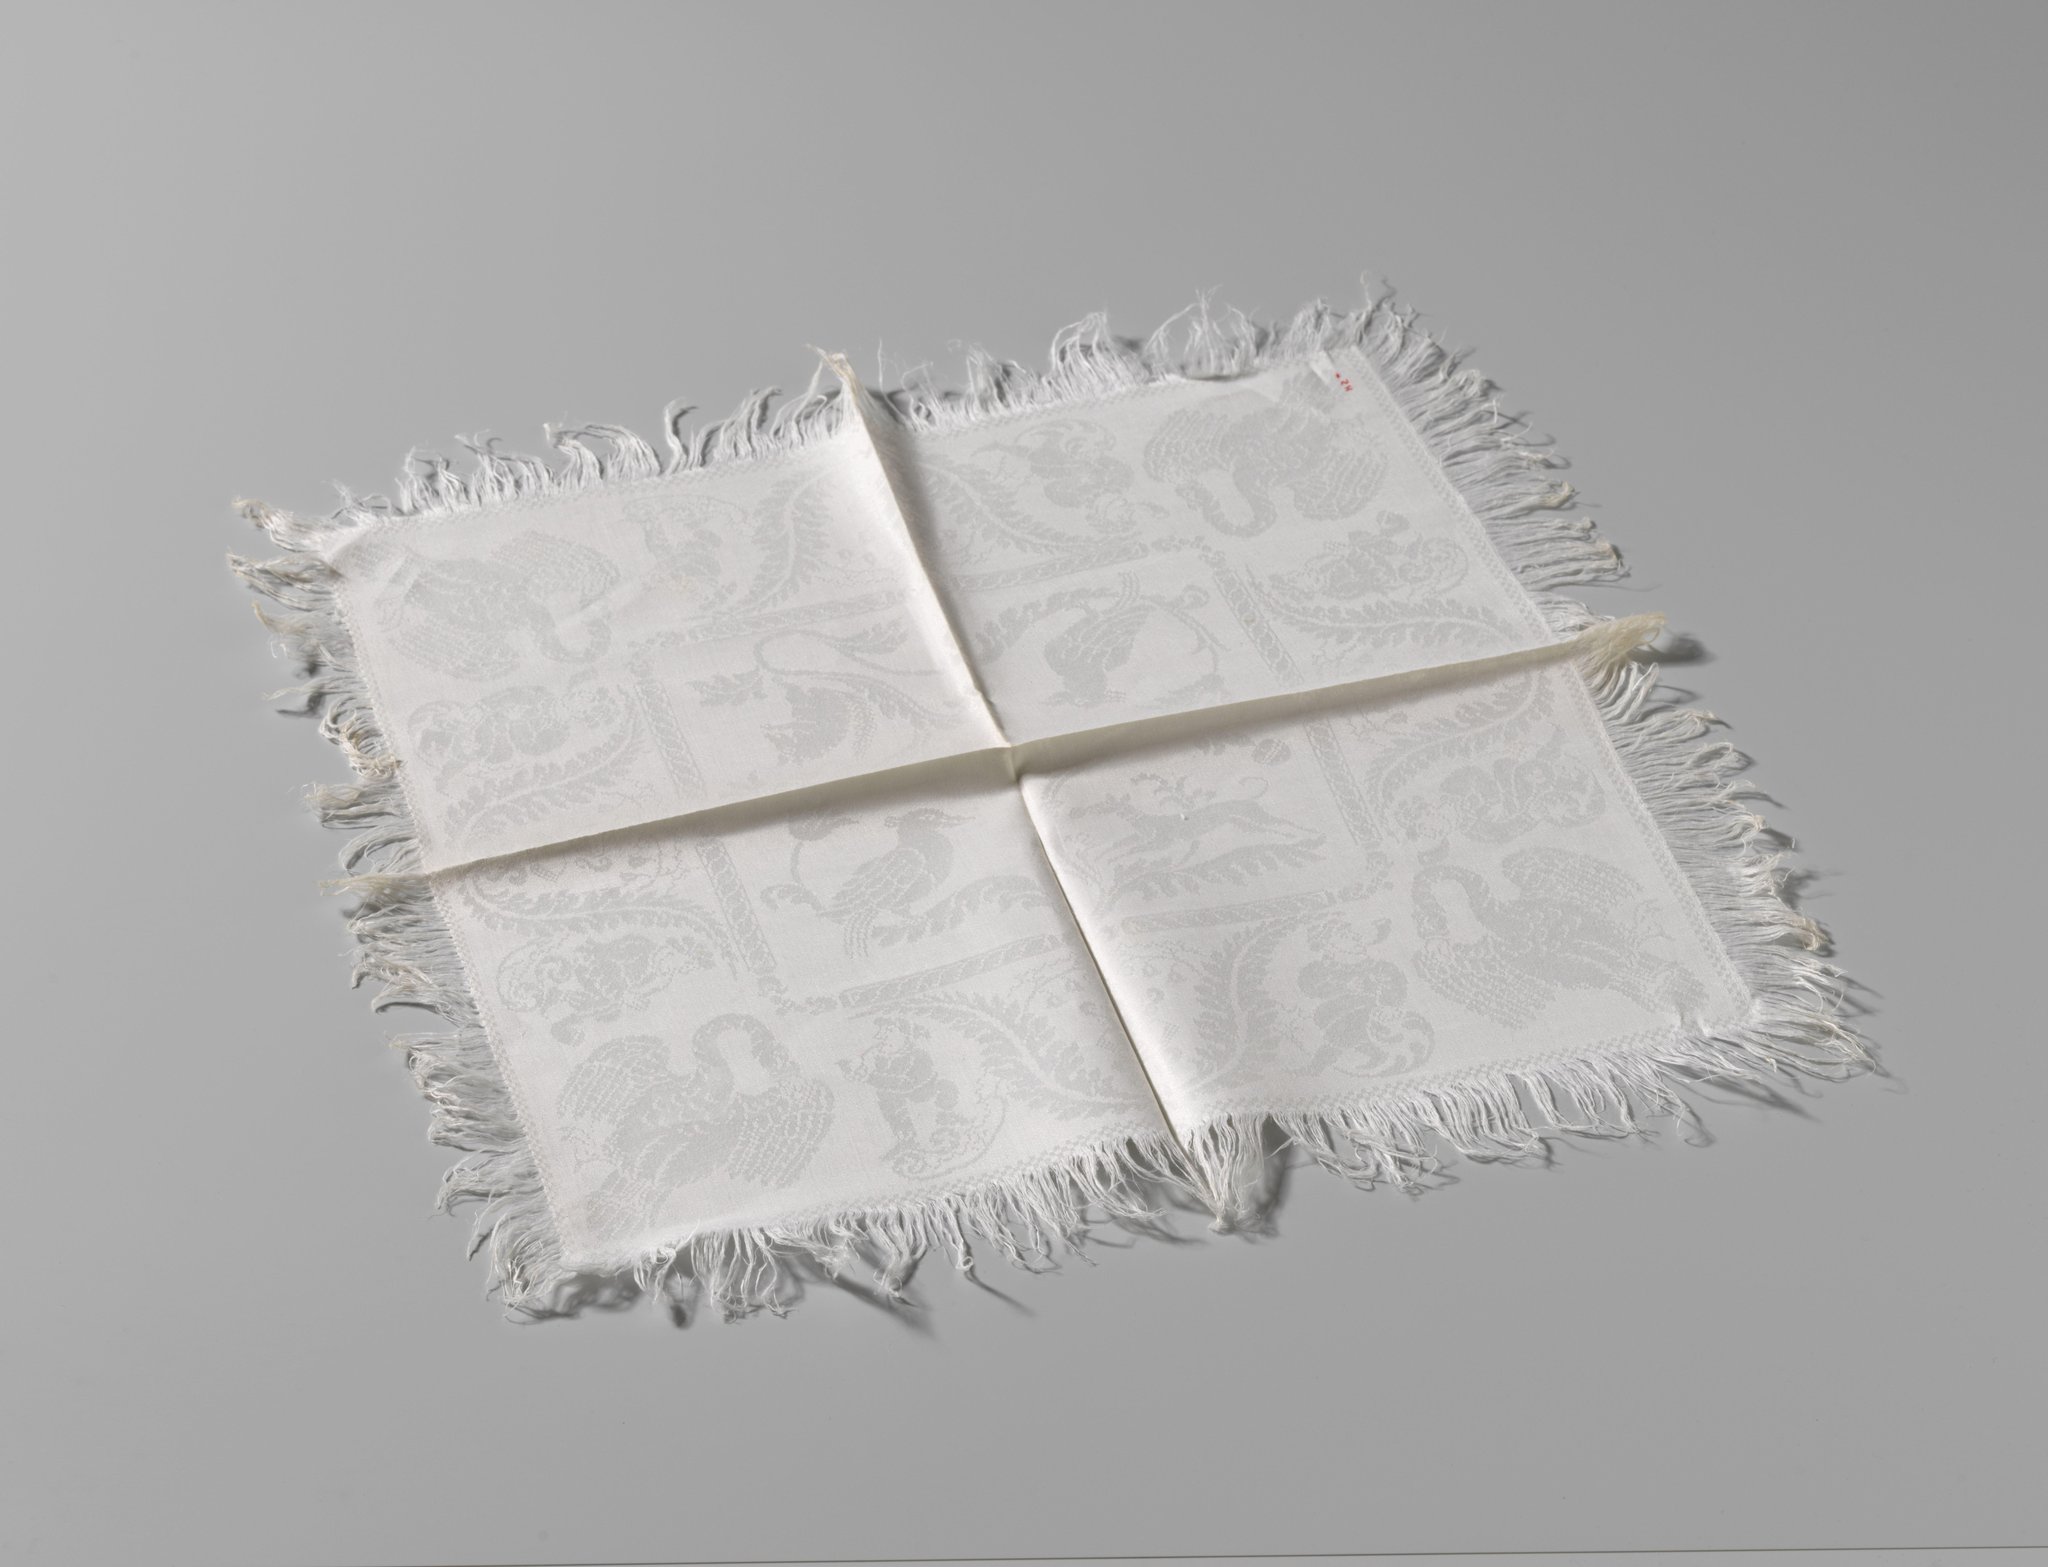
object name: vingerdoek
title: Pijprokende Turken.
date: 1850-1899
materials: linen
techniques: damask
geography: veghel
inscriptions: mark: ‘ZK’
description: Vingerdoek van wit linnendamast, met dessin van pijprokende Turken.